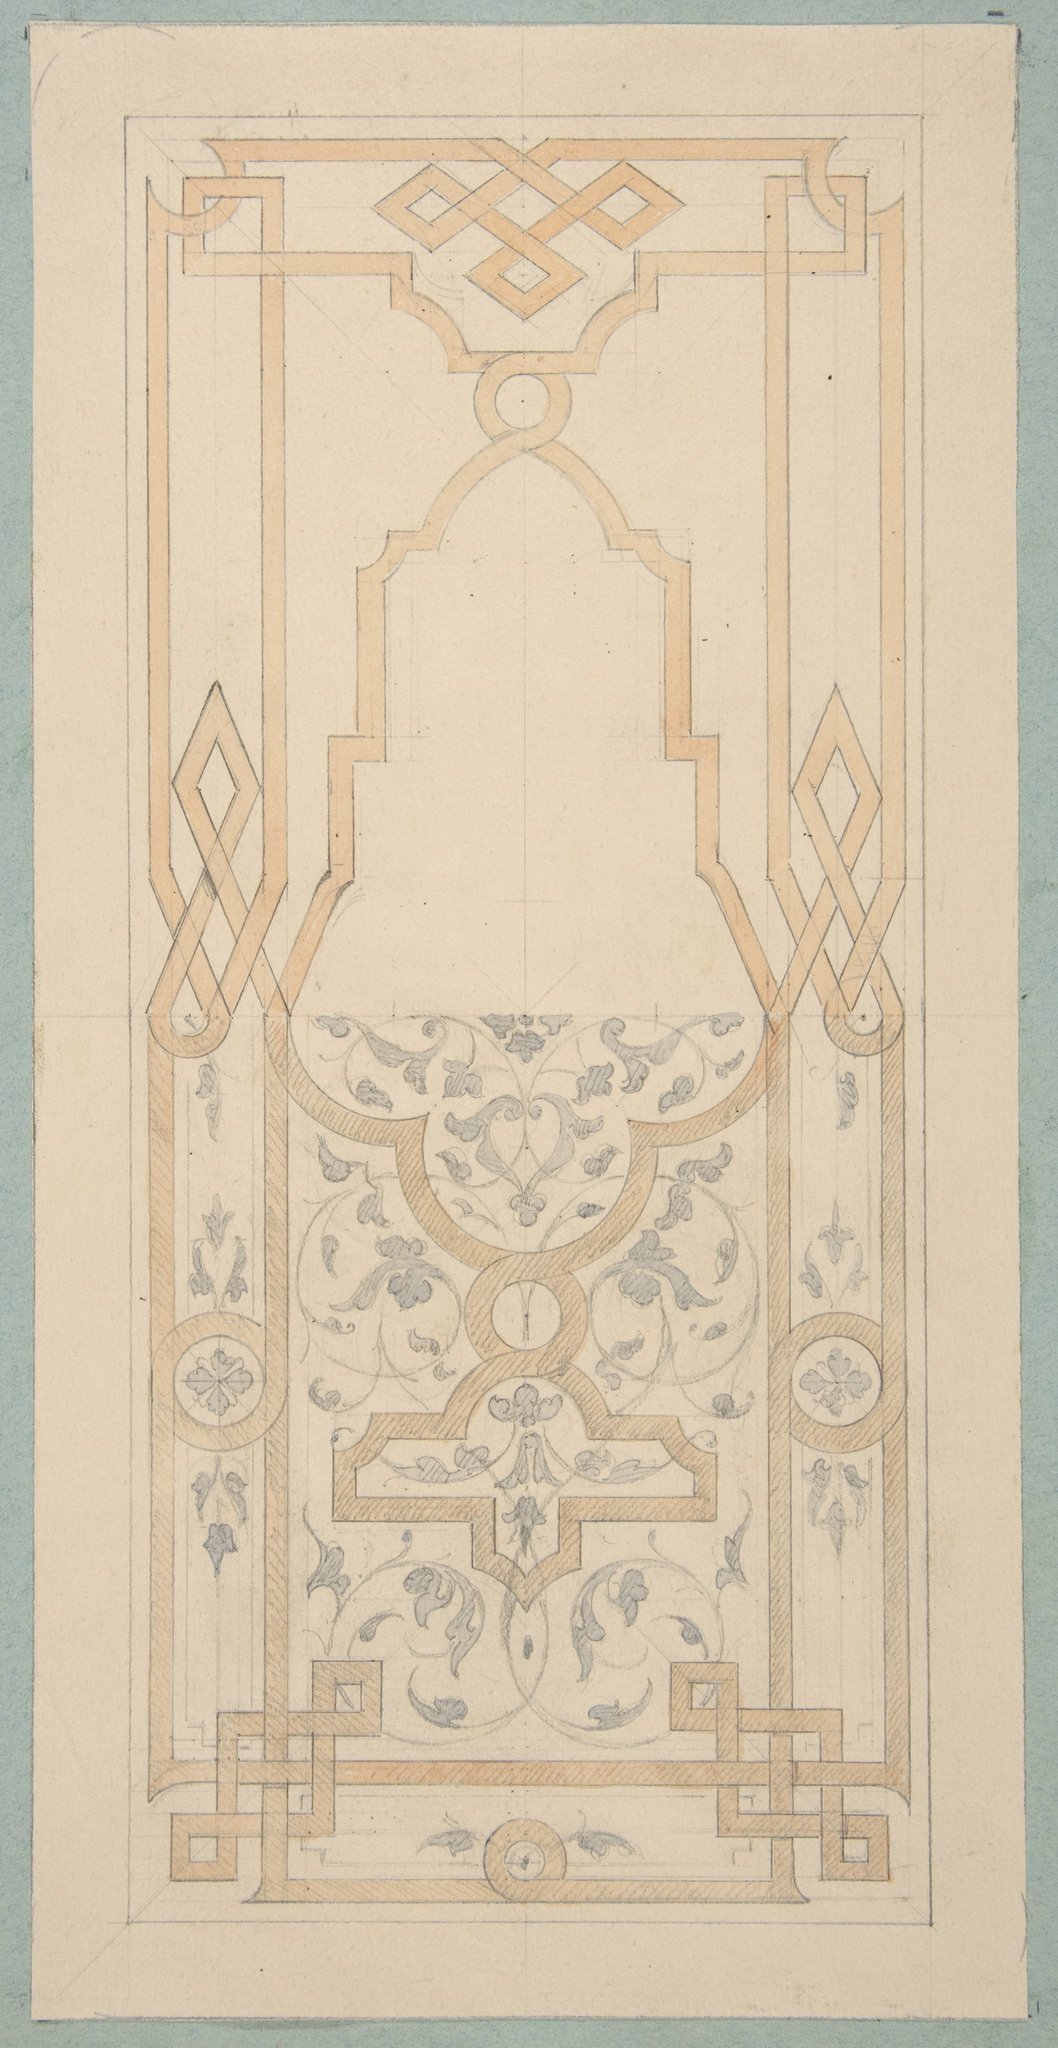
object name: drawing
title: Design for a panel ornamented with strapwork and rinceaux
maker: jules-edmond-charles lachaise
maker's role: artist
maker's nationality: french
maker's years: 1897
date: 1830-1897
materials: graphite, watercolor, paper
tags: ornament